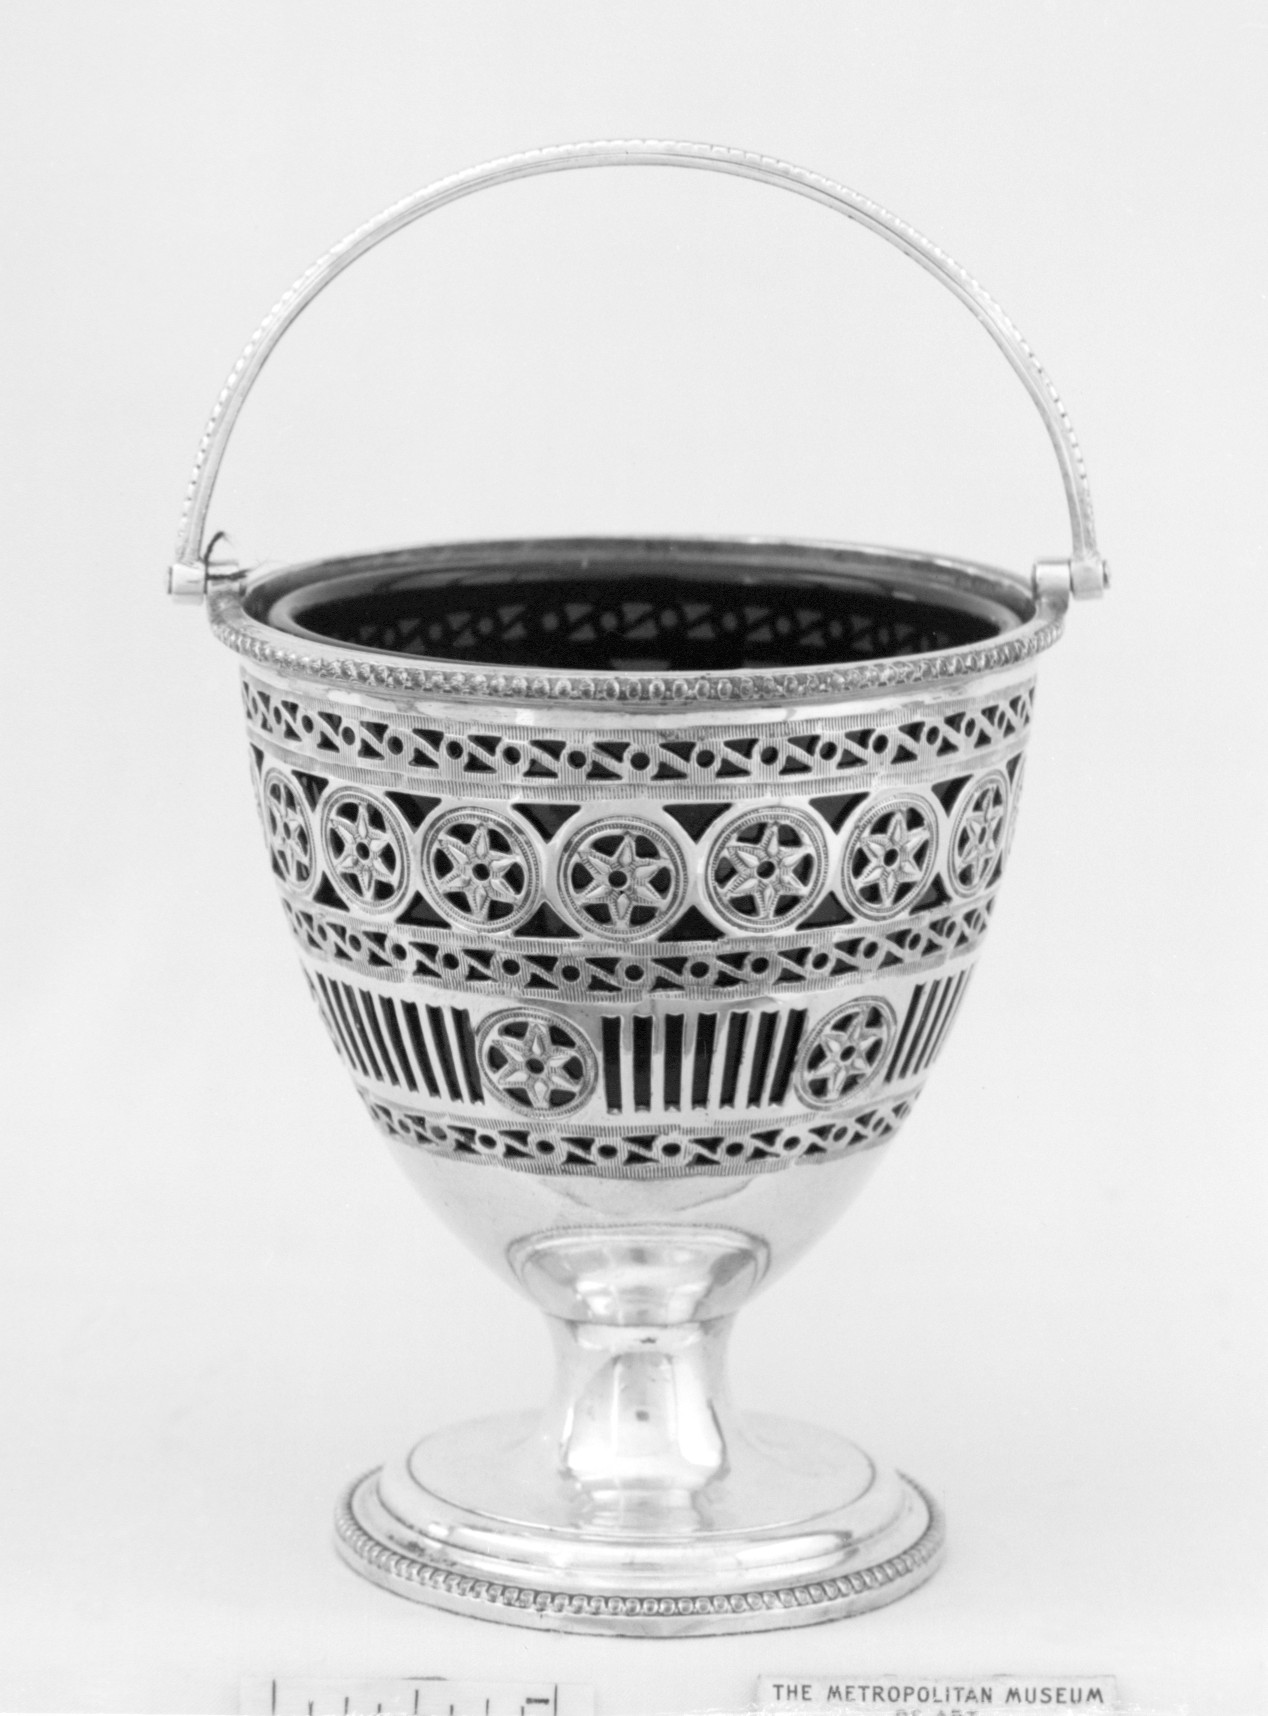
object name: sugar bowl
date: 1780-1785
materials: metal